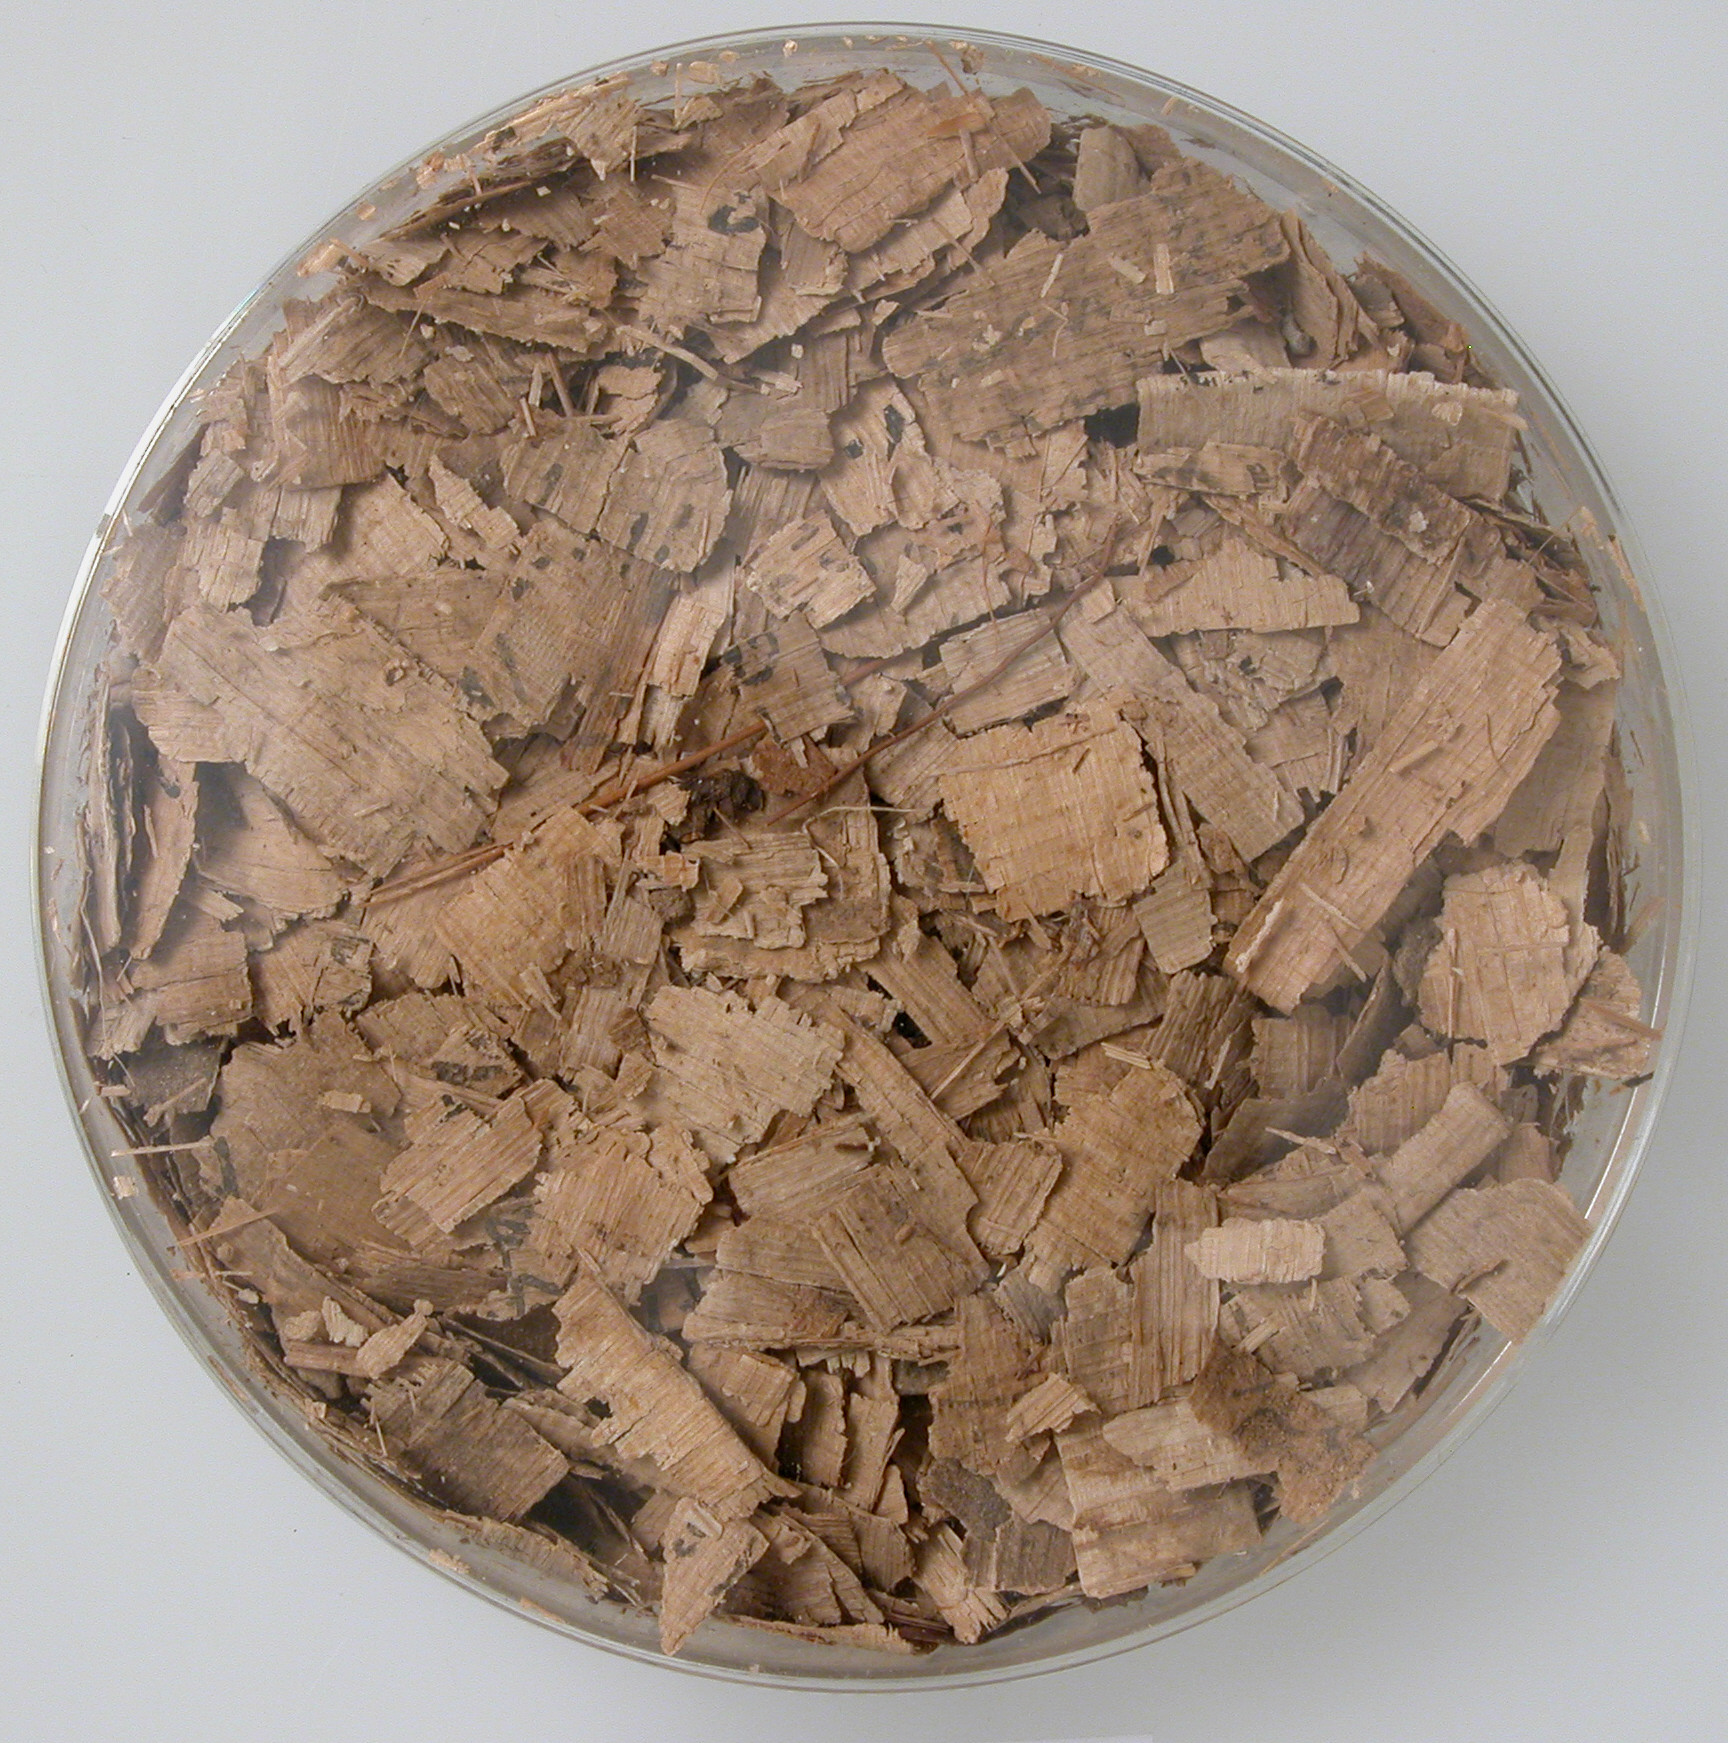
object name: fragment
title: Papyri Fragments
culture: coptic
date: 601-700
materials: ink, papyrus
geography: egypt